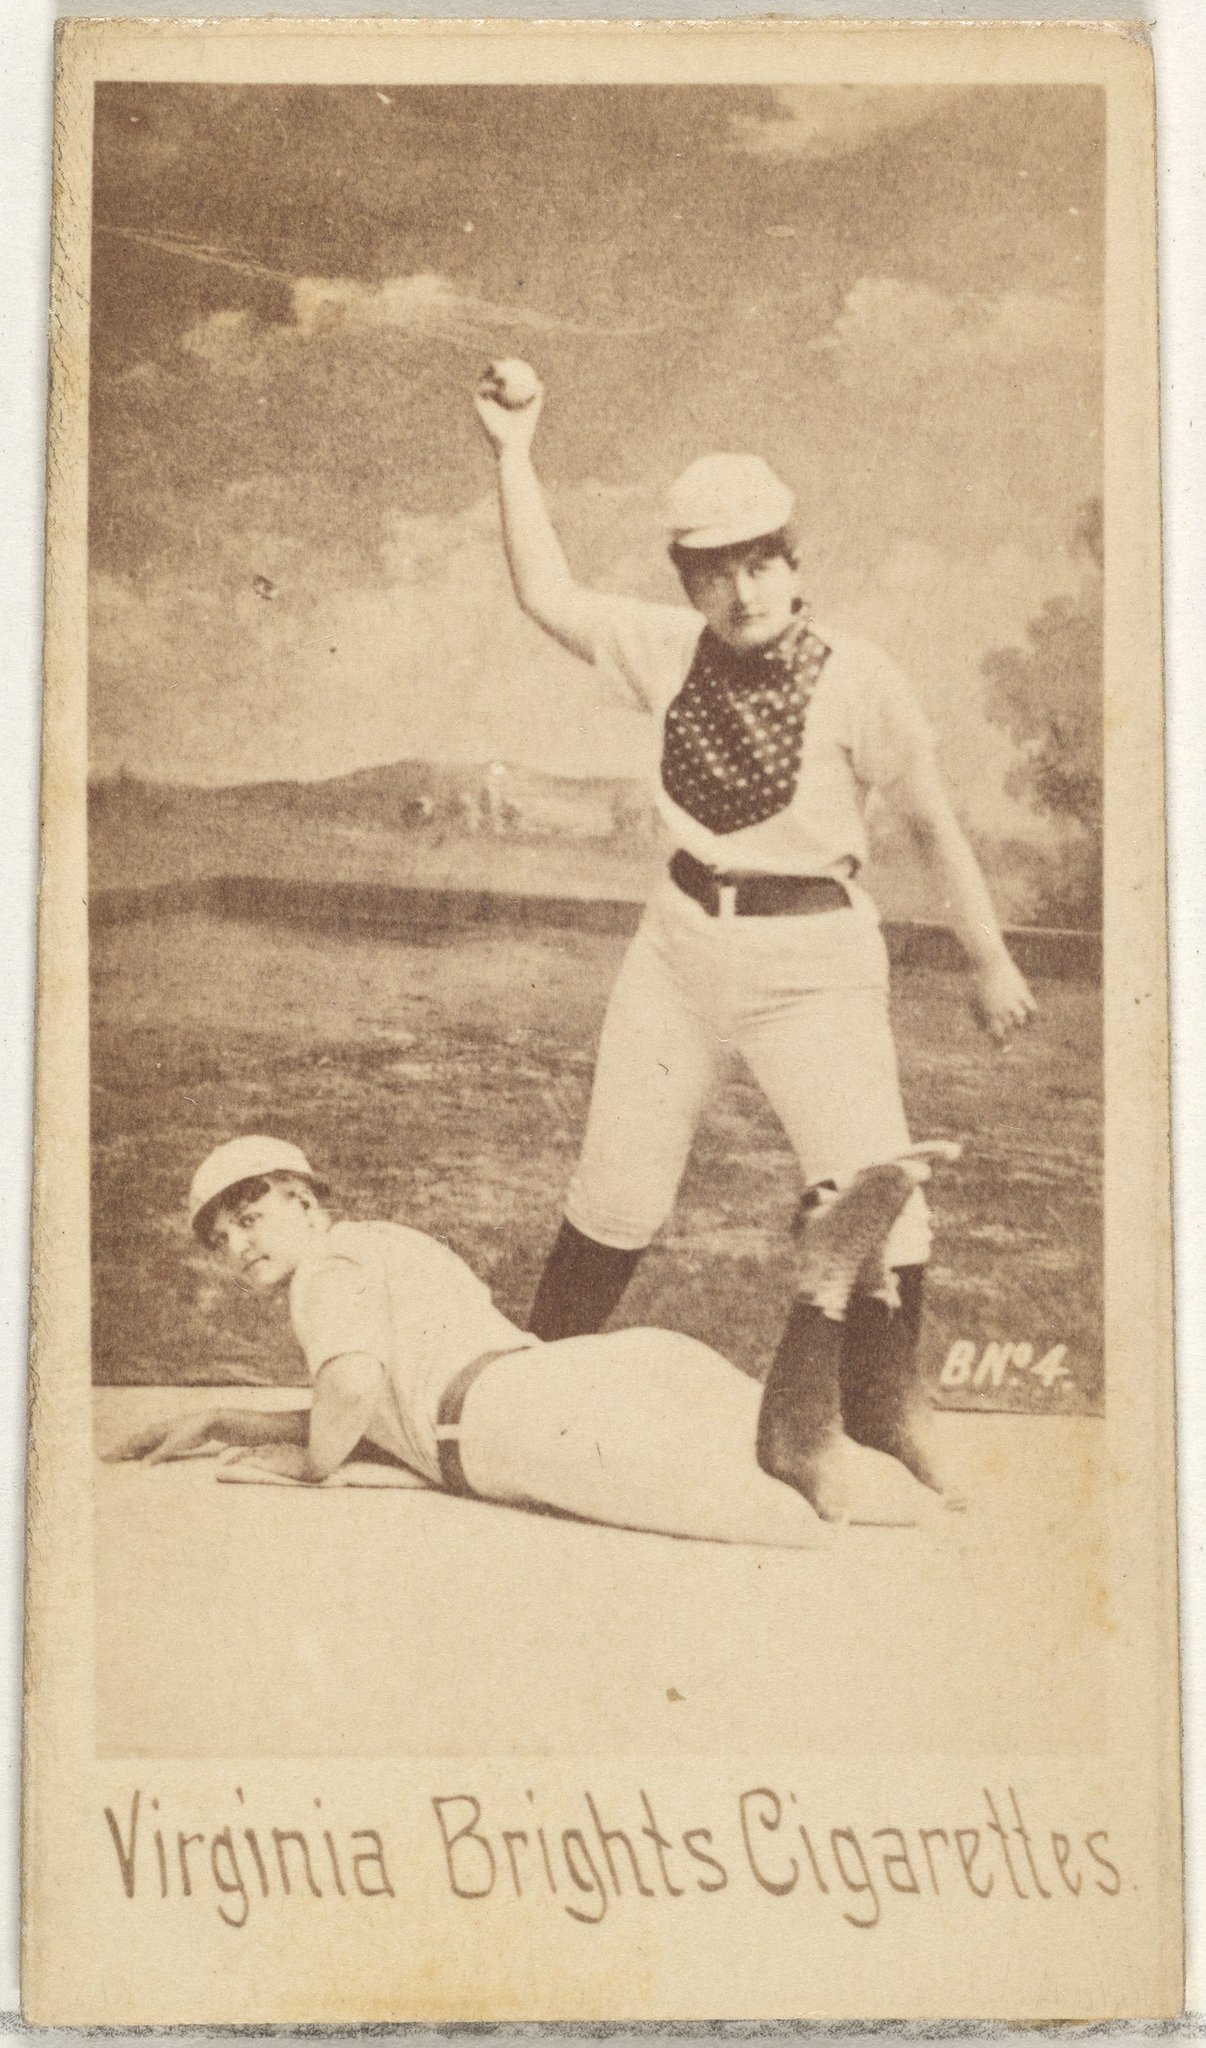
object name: baseball card, photograph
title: Card 4, from the Girl Baseball Players series (N48, Type 1) for Virginia Brights Cigarettes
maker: allen & ginter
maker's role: publisher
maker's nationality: american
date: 1886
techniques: albumen silver print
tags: portraits,women,baseball,athletes